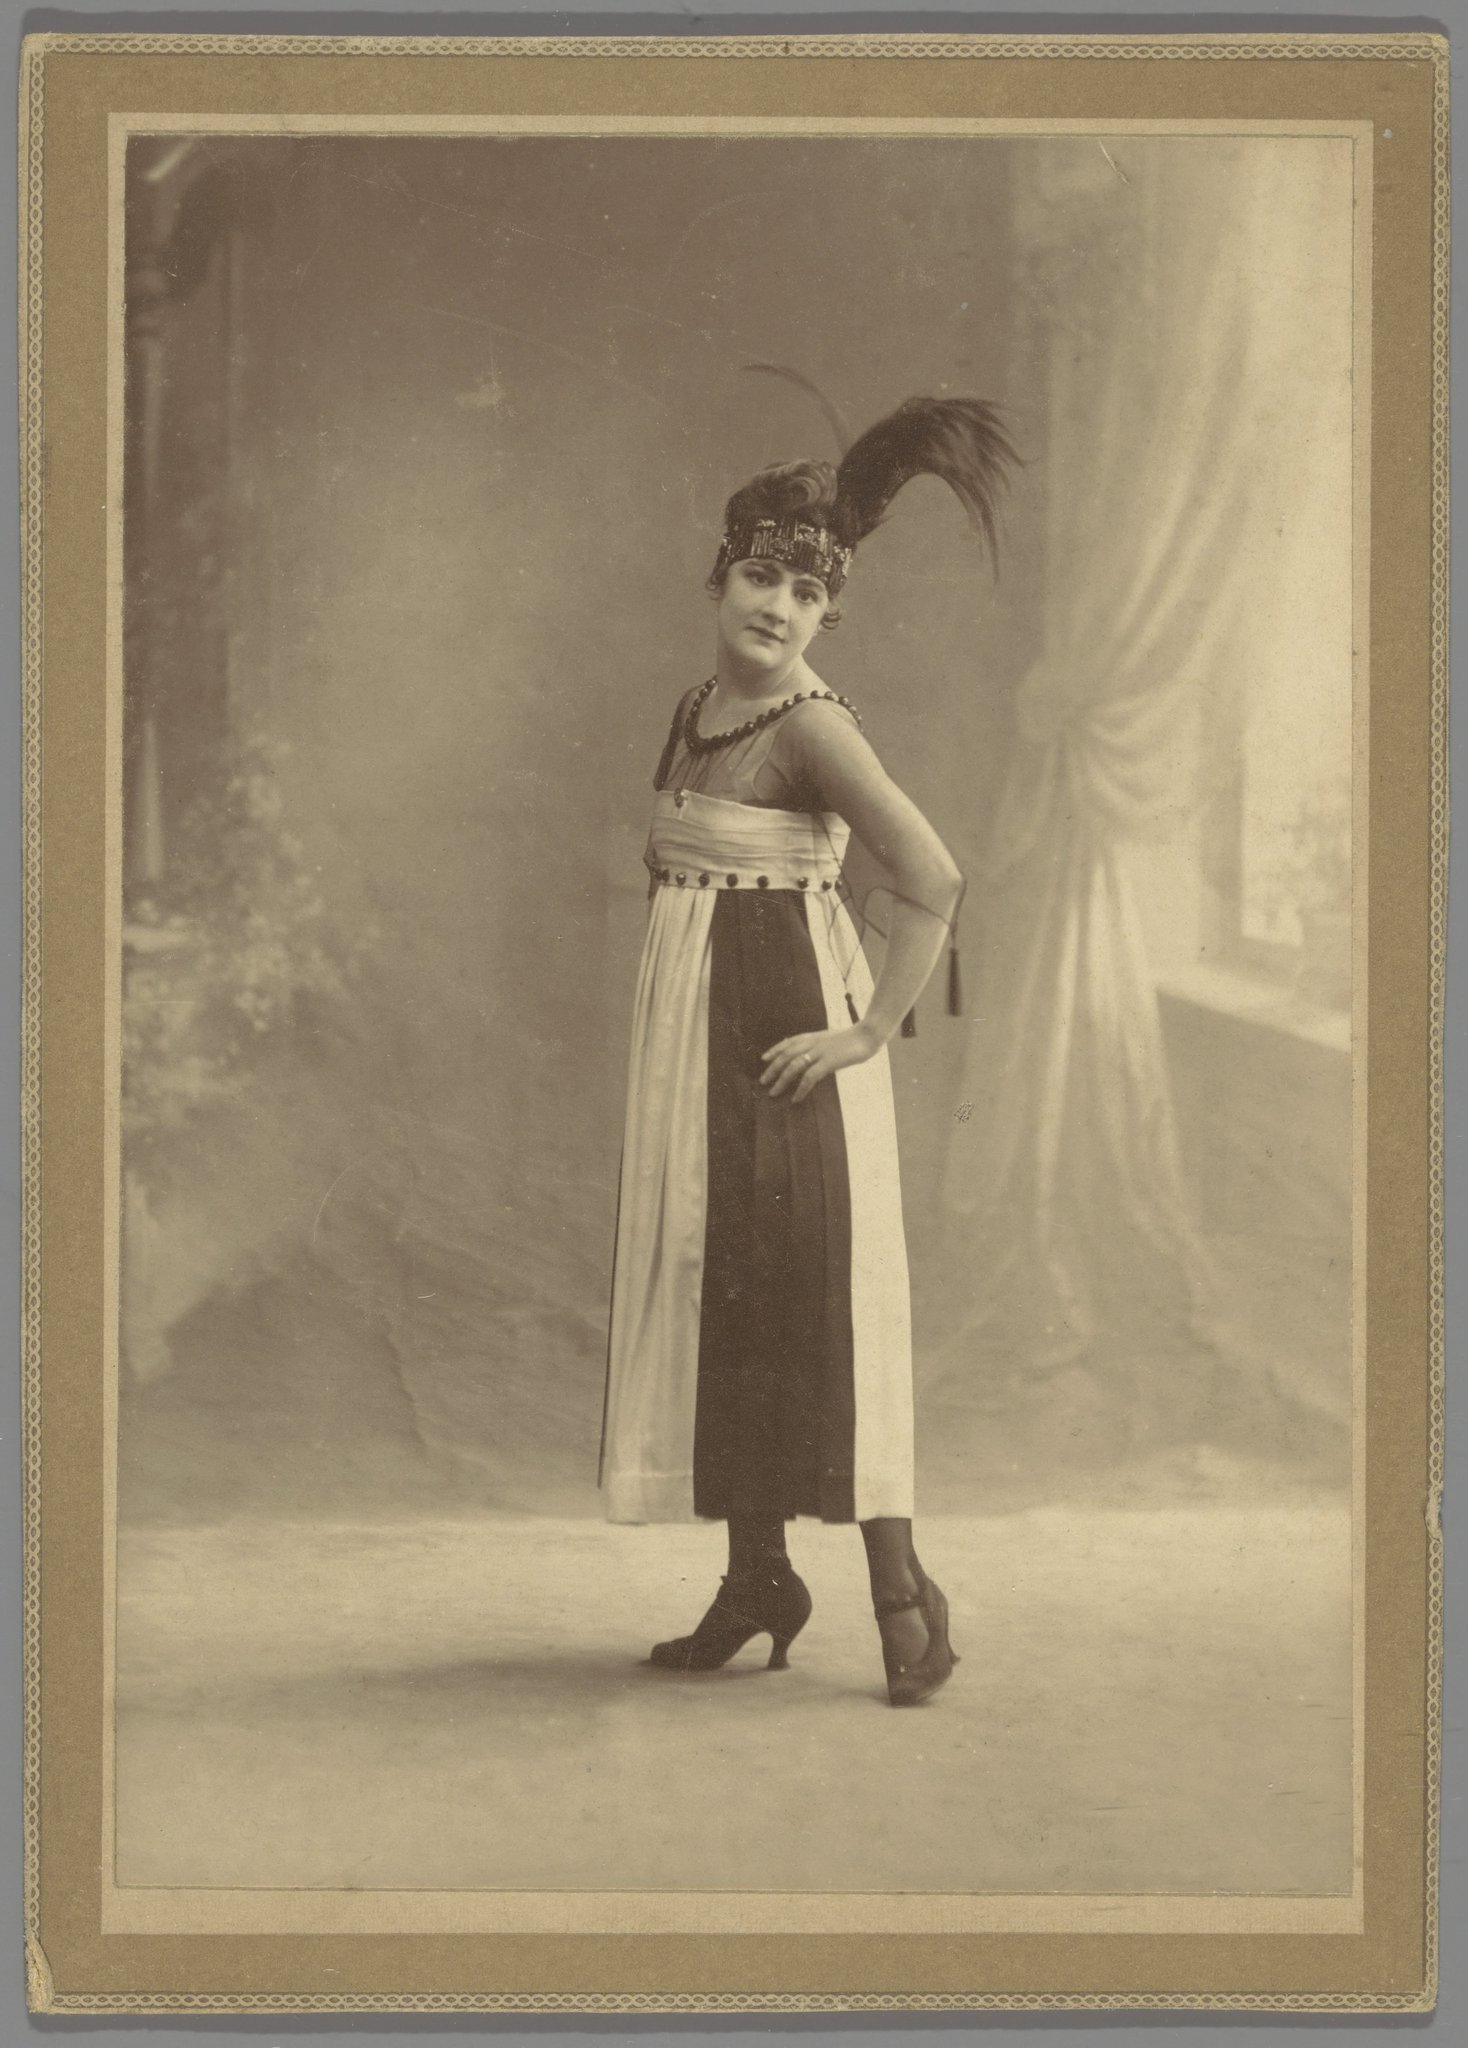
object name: photograph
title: Portret van Jeane d'Elsing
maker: Anonymous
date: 1916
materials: paper, cardboard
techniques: matte daylight collodion silver print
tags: historical persons - bb - woman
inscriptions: inscription: ‘Jeane d'Esling 1916’